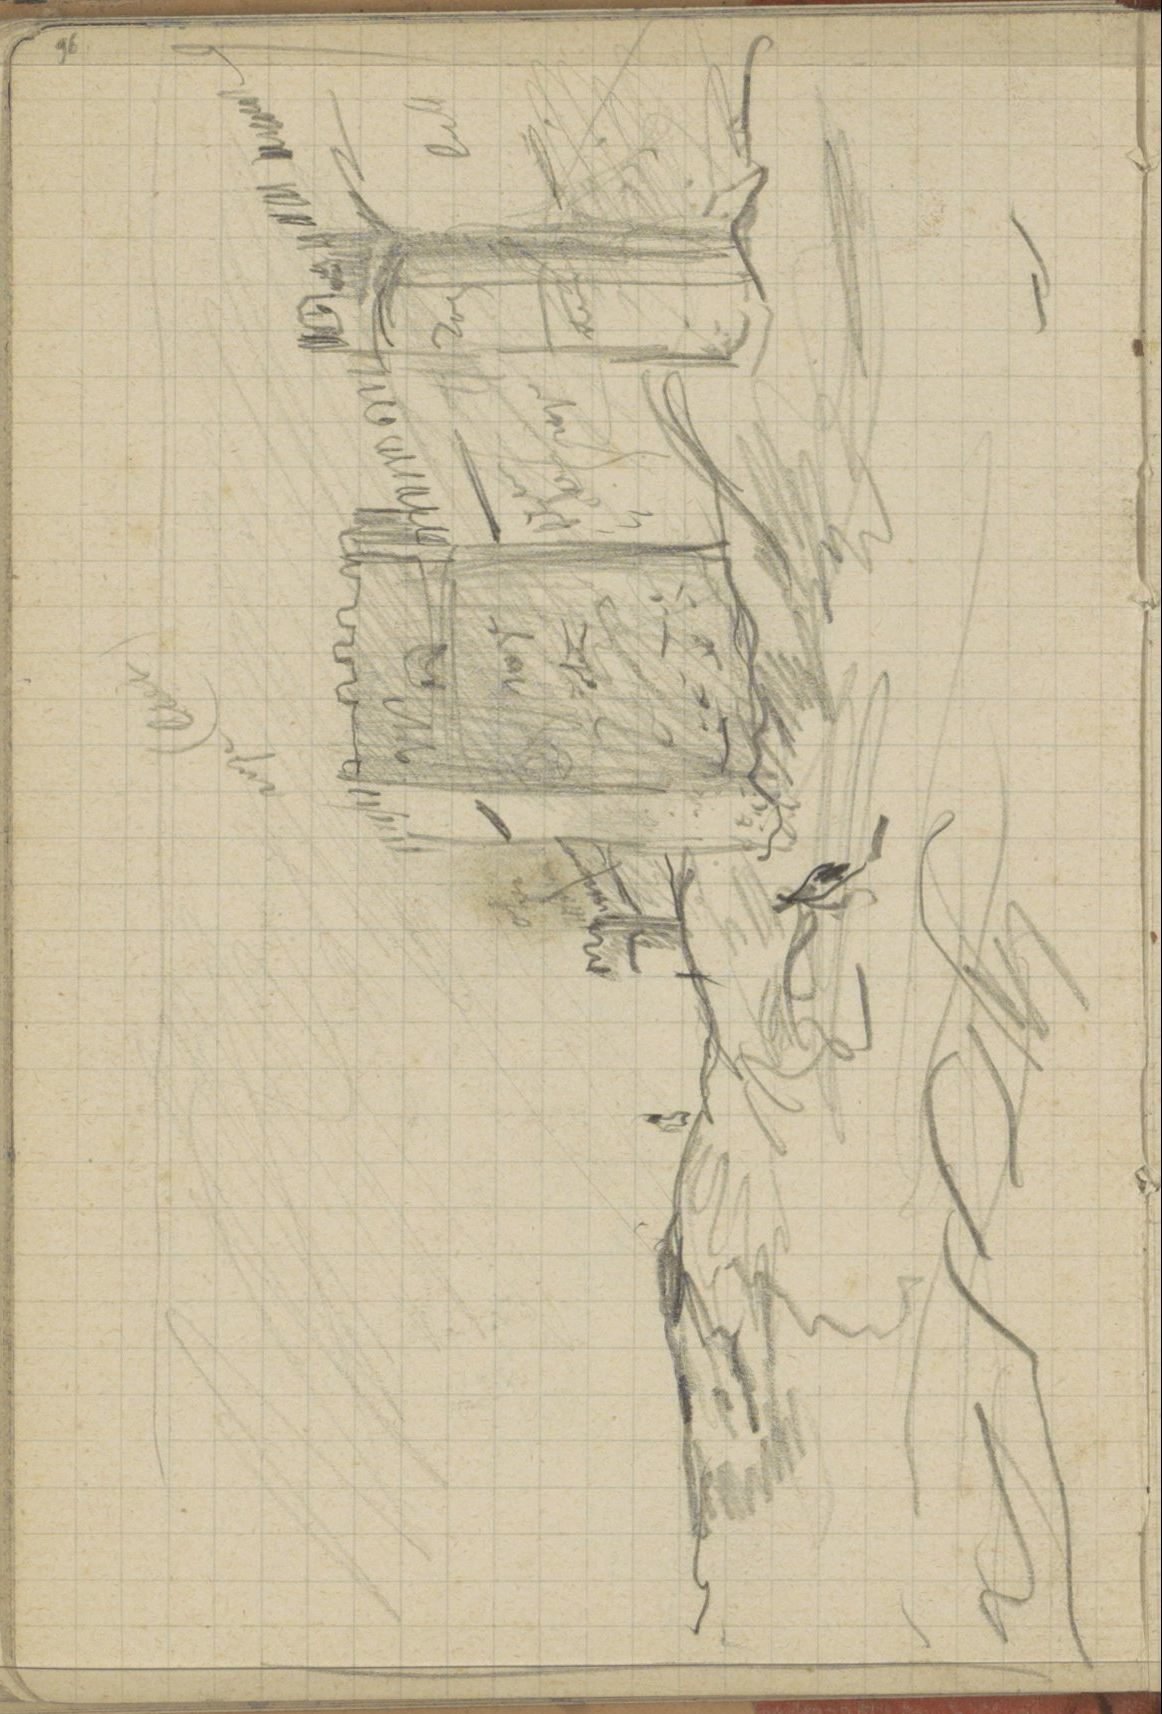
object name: sketchbook leaf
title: Stadsmuur met verdedigingstorens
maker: marius bauer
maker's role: draughtsman, print maker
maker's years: 1867-1932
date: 1909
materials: pencil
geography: tunisia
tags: city-view, and landscape with man-made constructions, towers ~ fortified city, walls ~ fortified city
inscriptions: kleurnotitie, handgeschreven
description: Mogelijk de stadsmuur van Kairouan. Pagina 96 uit een schetsboek met 67 bladen.